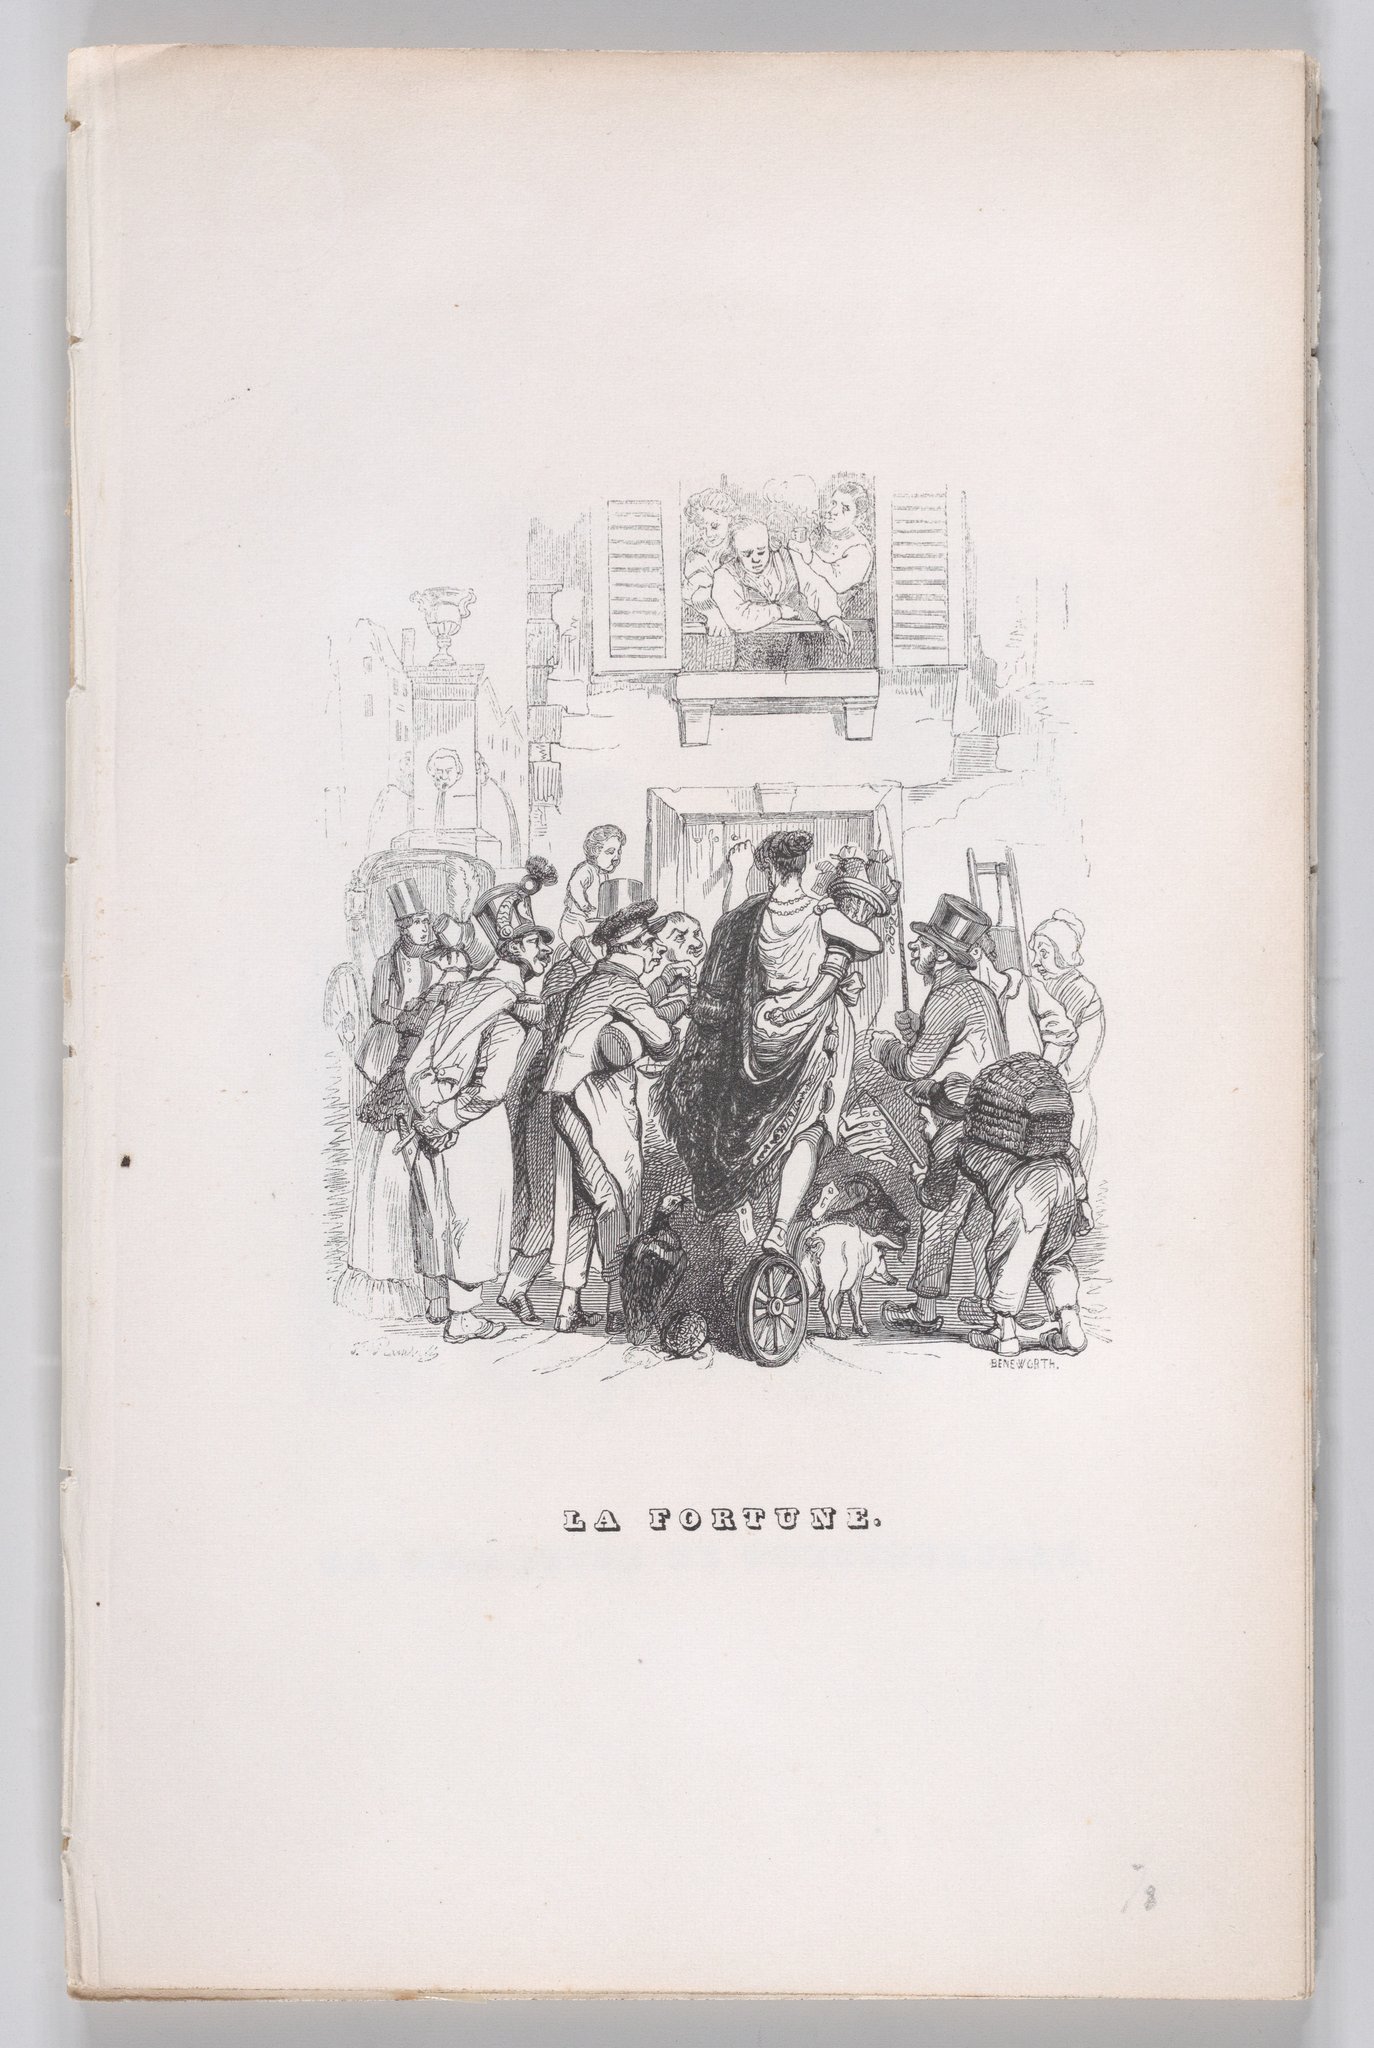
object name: print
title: Fortune, from "The Complete Works of Béranger"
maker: j. j. grandville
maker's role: illustrator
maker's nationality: french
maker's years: 1803-1847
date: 1836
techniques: engraving